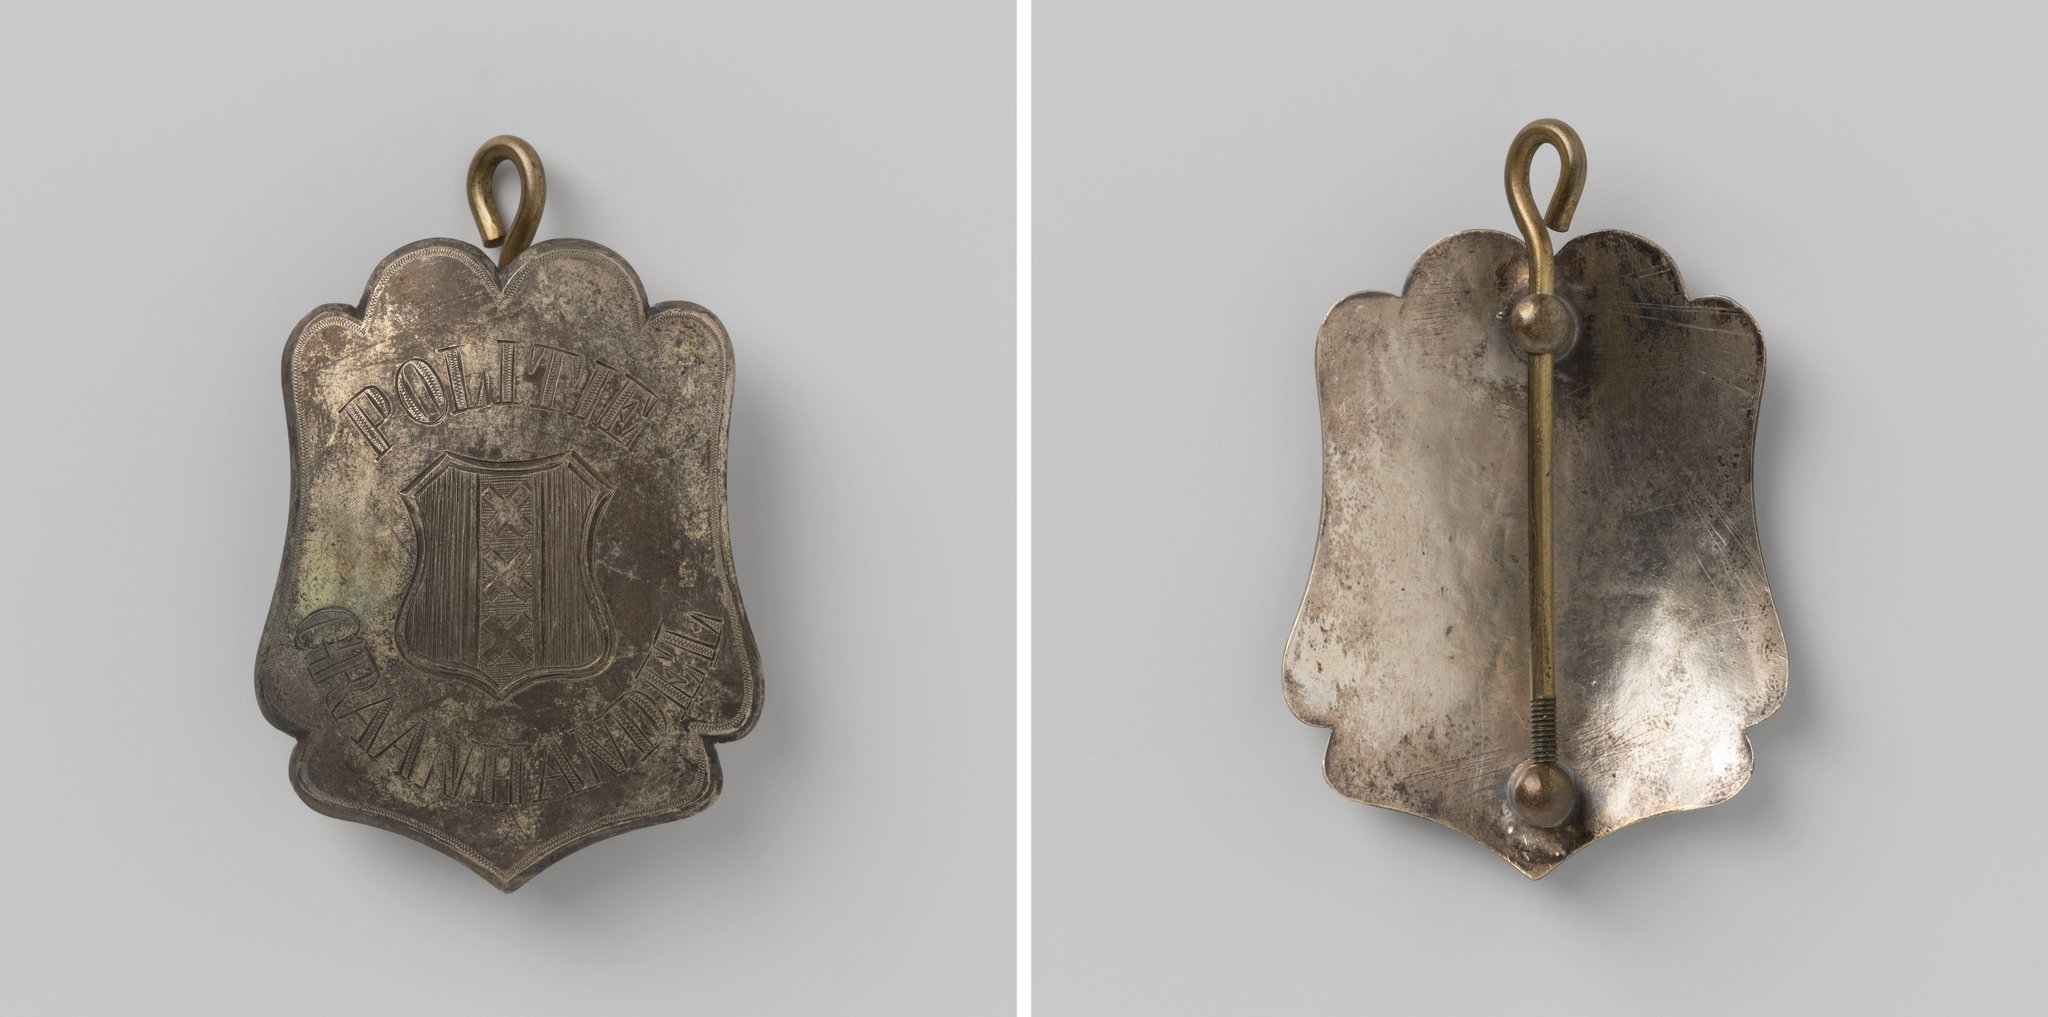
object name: lidmaatschapspenning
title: Politie van toezicht op de graanhandel te Amsterdam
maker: Anonymous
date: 1800-1885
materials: silver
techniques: engraving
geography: amsterdam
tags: coat of arms (as symbol of the state, etc.) (+ city; municipal), amsterdam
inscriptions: : ‘politie graanhandel’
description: Naar beneden toe verbredende, langwerpige, bolle, zilveren plaquette, aan bovenzijde met vier lobben en aan onderzijde uitlopend in punt, gemonteerd op twee pinnen, waardoor een lange pen met schroefdraad steekt. Voorzijde: wapenschild binnen omschrift.